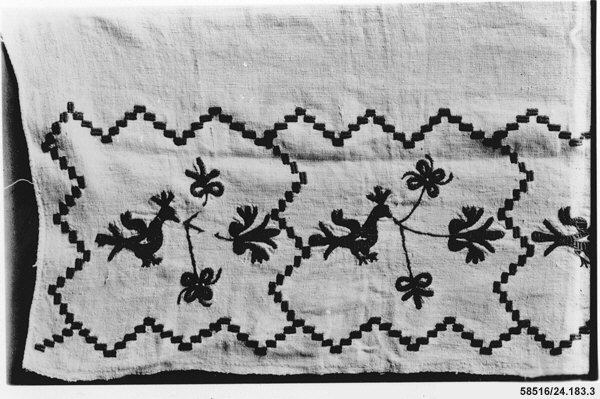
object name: bed valance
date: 1701-1800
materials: linen, wool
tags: birds,flowers